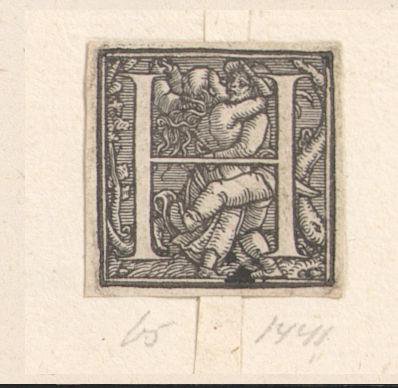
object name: print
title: Latijns alfabet met boeren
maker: hans lützelburger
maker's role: print maker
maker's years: -1526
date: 1525-1526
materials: paper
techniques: woodcut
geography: basel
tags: initial, one pair dancing; man and woman dancing as a couple, farmers